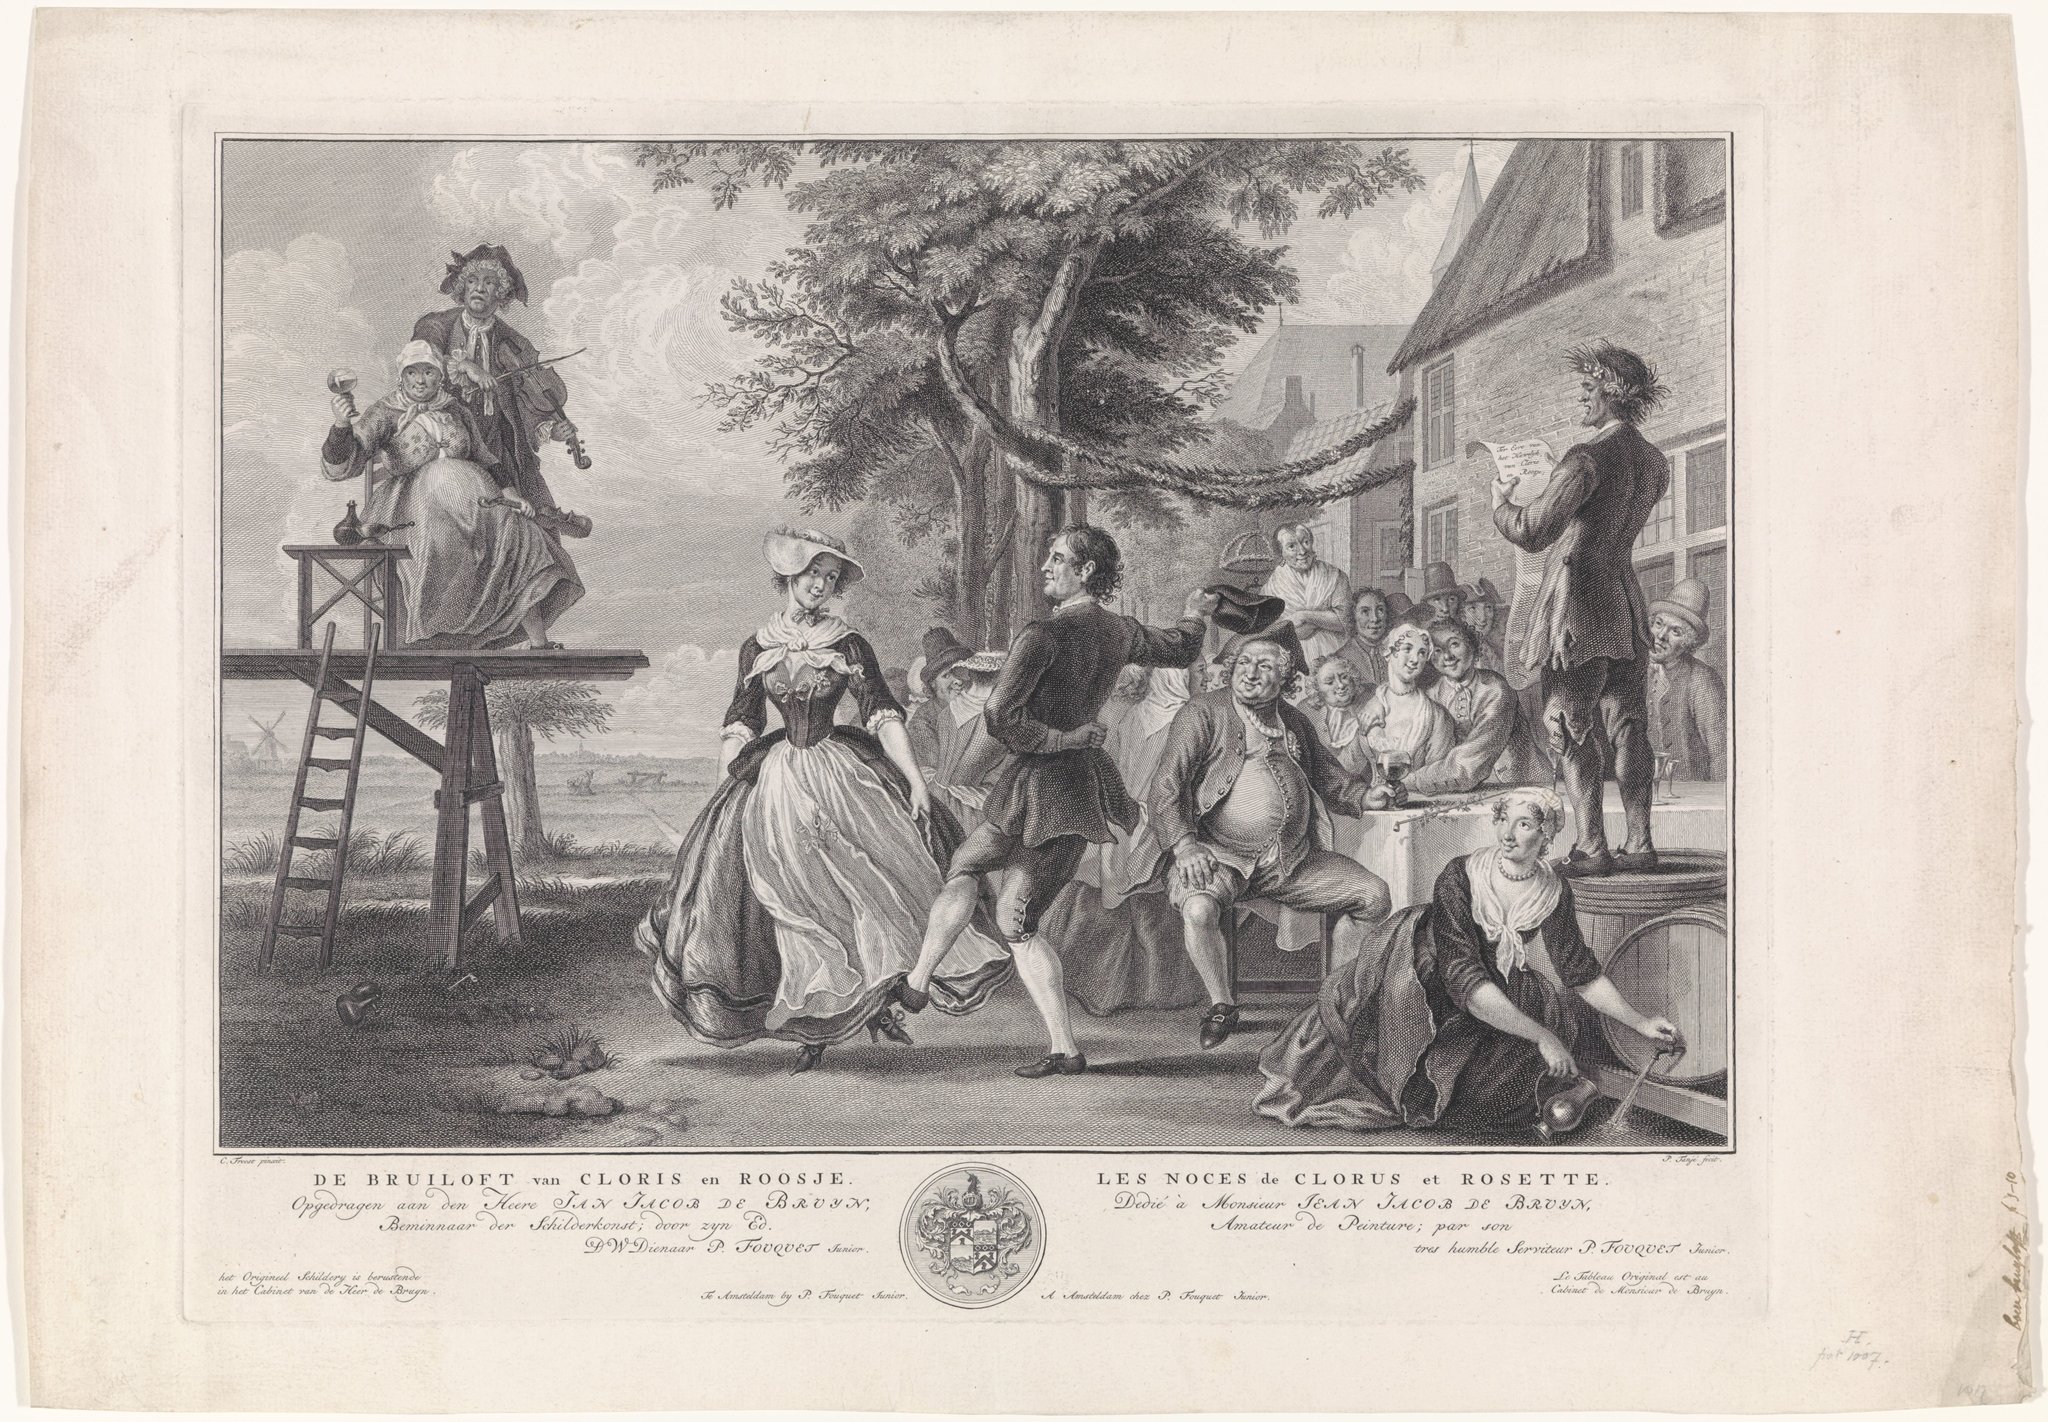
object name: print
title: Bruiloft van Cloris en Roosje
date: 1752-1761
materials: paper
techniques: engraving, etching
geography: amsterdam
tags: violin, fiddle, dancing at wedding feast - dd - out of doors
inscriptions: collector's mark: Lugt 2228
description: Cloris en Roosje dansen op hun bruiloft. Op de verhoging twee vioolspelers, van wie de vrouw het glas heft. Rechts de feestgangers en een man, die vanaf een ton een toespraak houdt. Onderaan in de marge het wapenschild van en een opdracht aan Jan Jacob de Bruyn, die het originele schilderij in zijn verzameling had. Scène uit het zangspel De bruiloft van Cloris en Roosje.